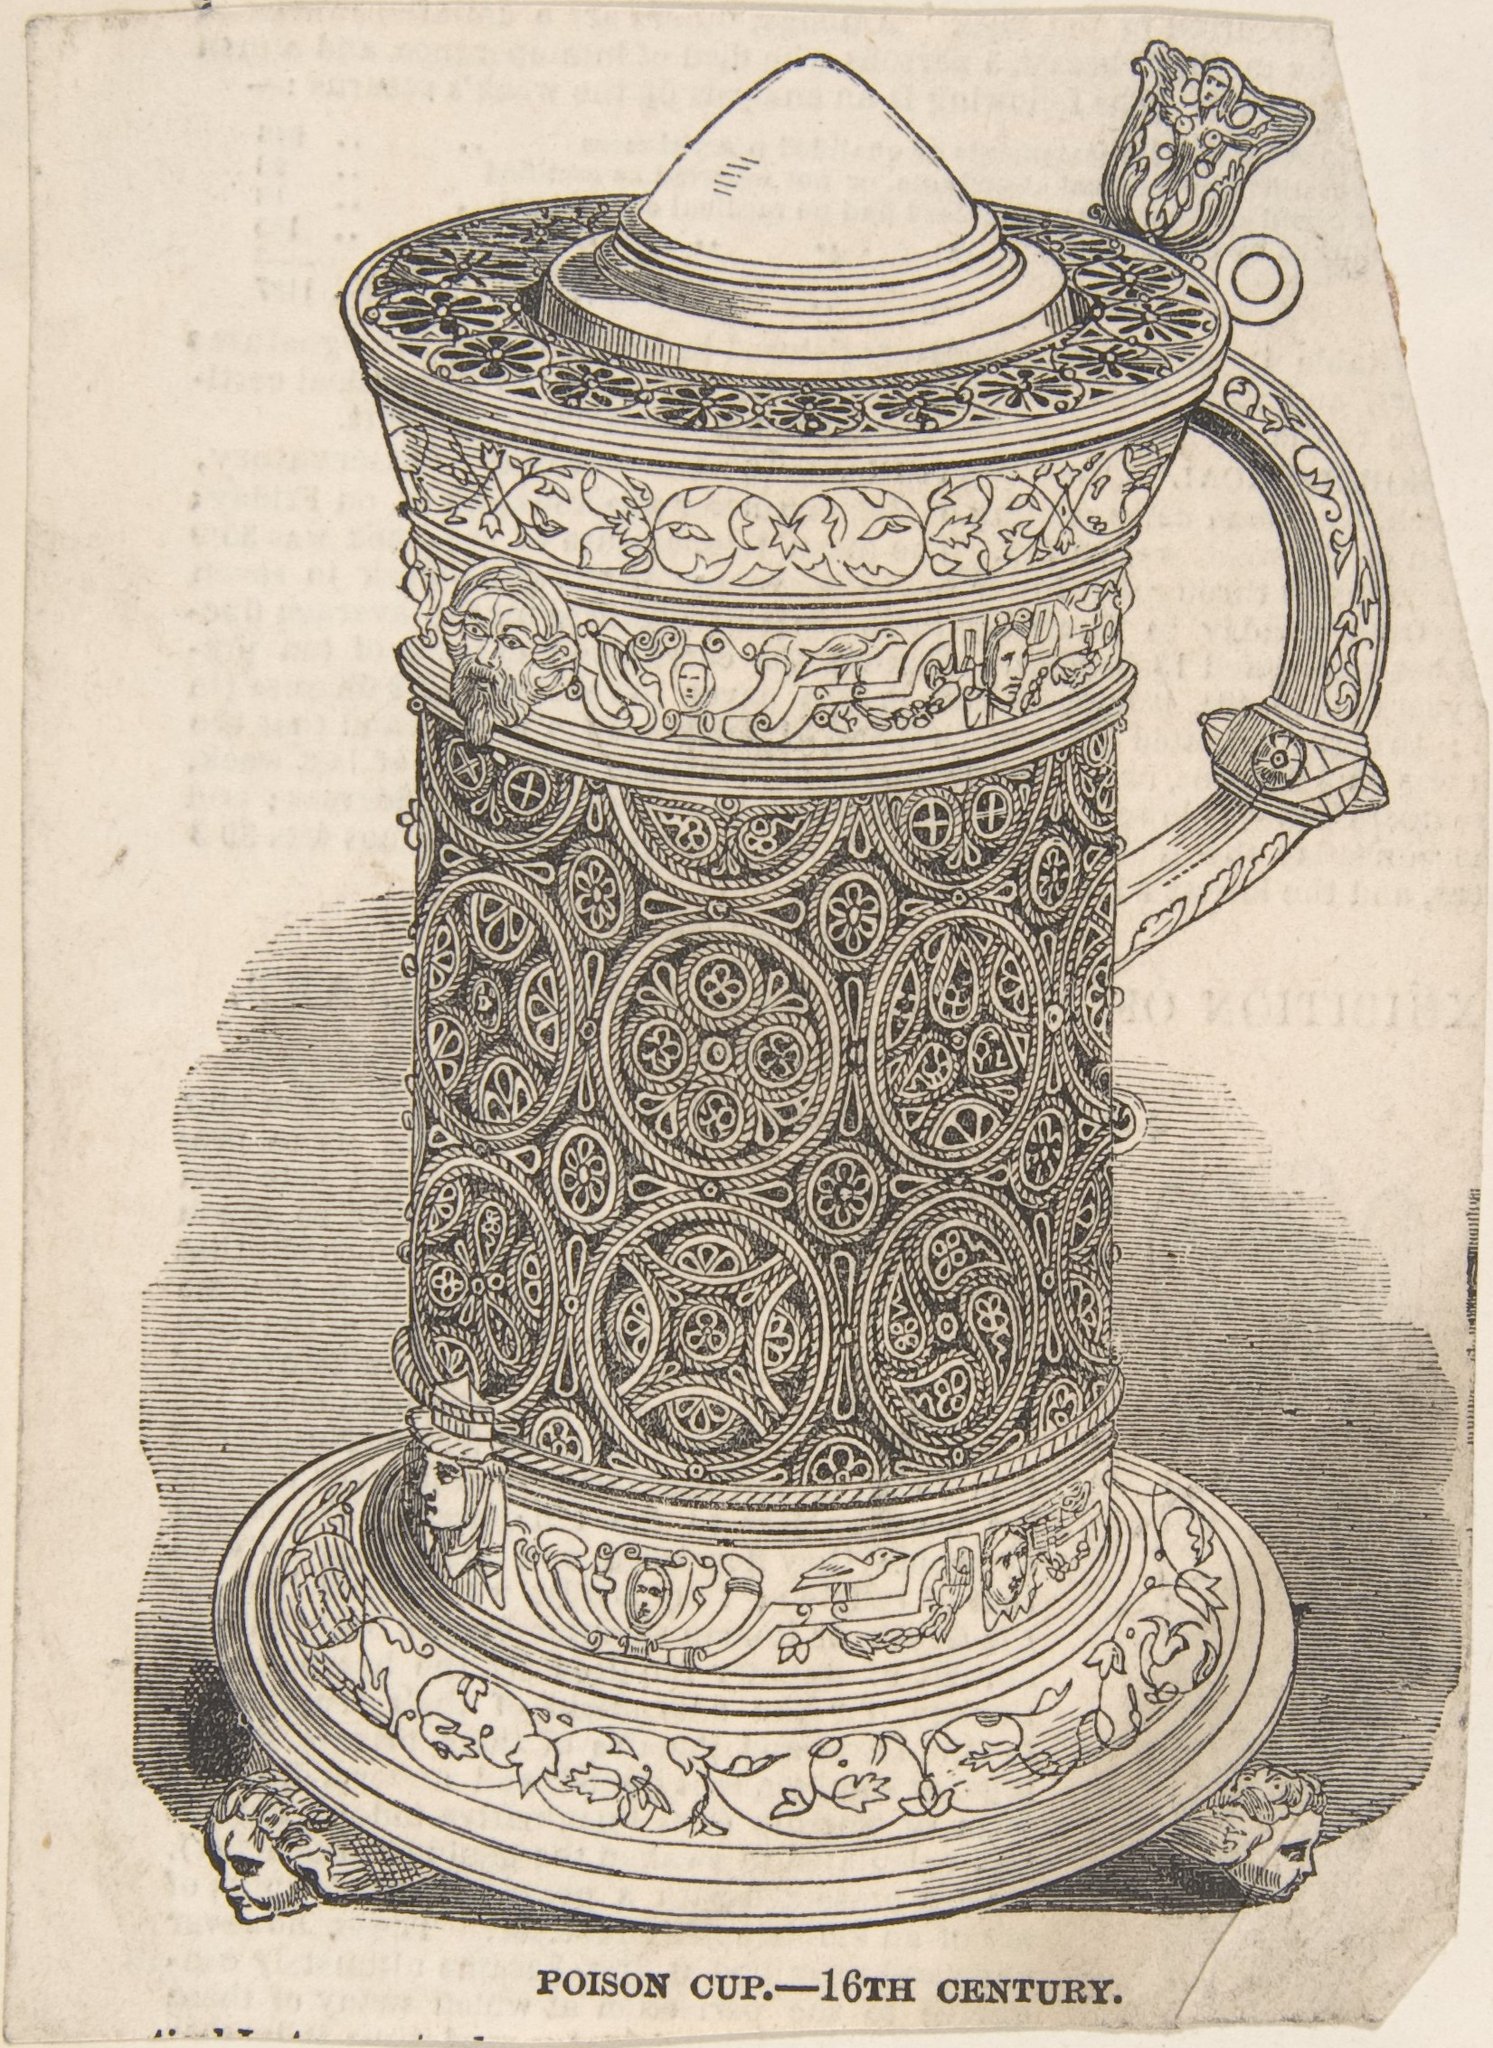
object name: print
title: Poison Cup - 16th century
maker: anonymous, british, 19th century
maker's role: artist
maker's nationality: british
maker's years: 1800-1900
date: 1851-1900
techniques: engraving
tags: cups